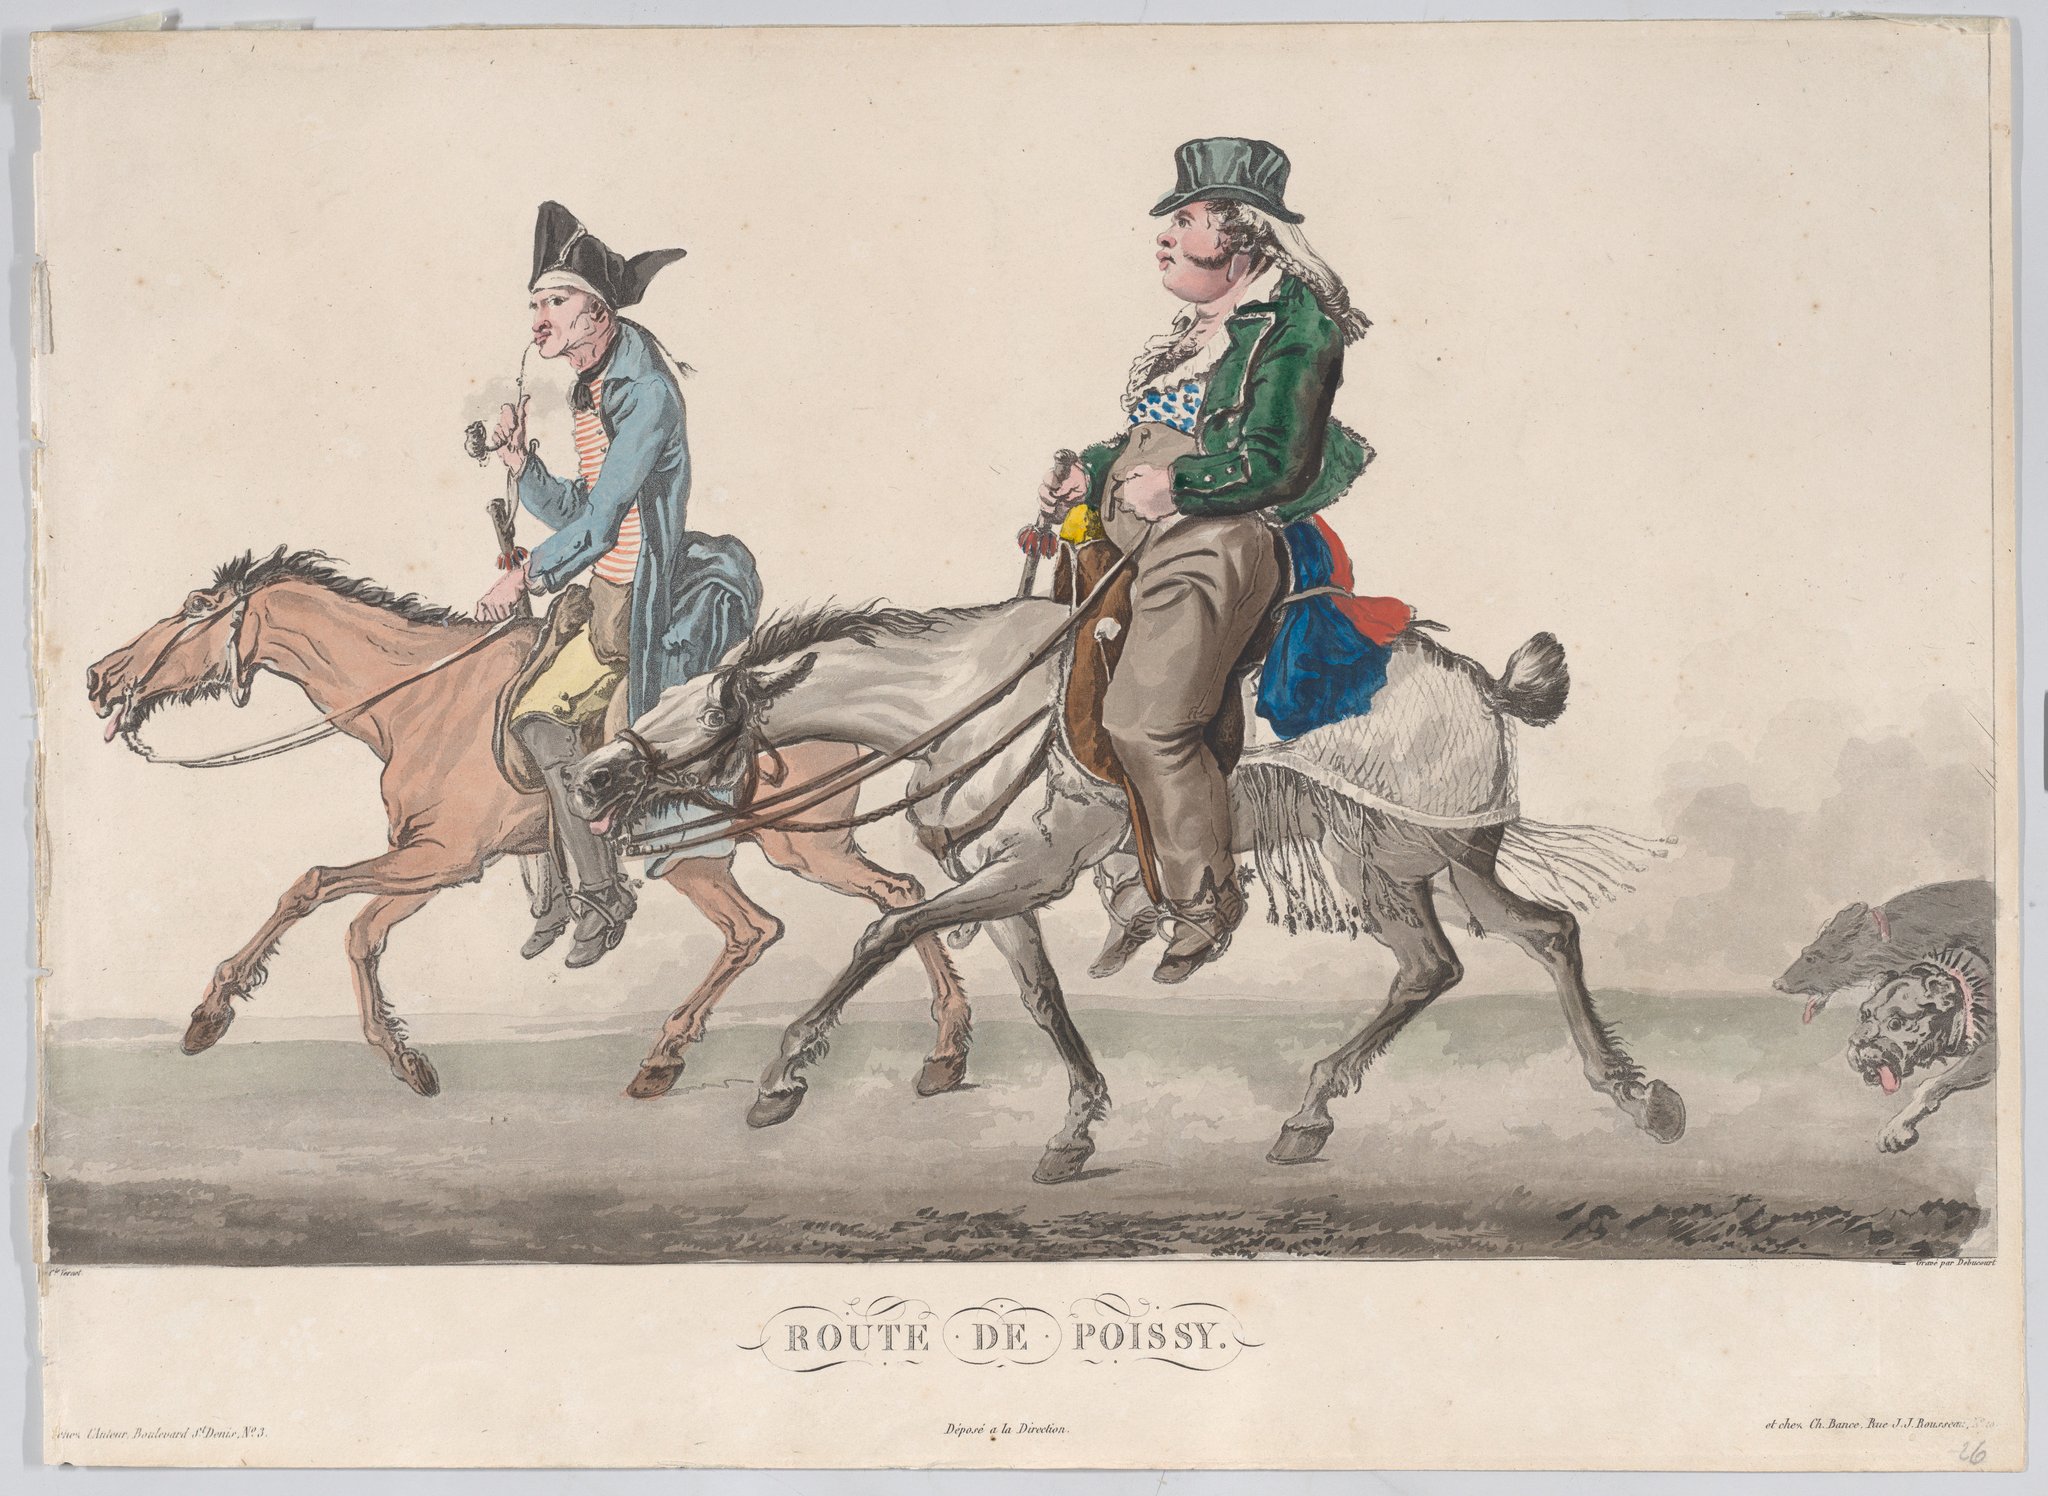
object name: print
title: Route de Poissy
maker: louis philibert debucourt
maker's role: artist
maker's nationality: french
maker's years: 1755-1832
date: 1816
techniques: aquatint, etching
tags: men,dogs,horses